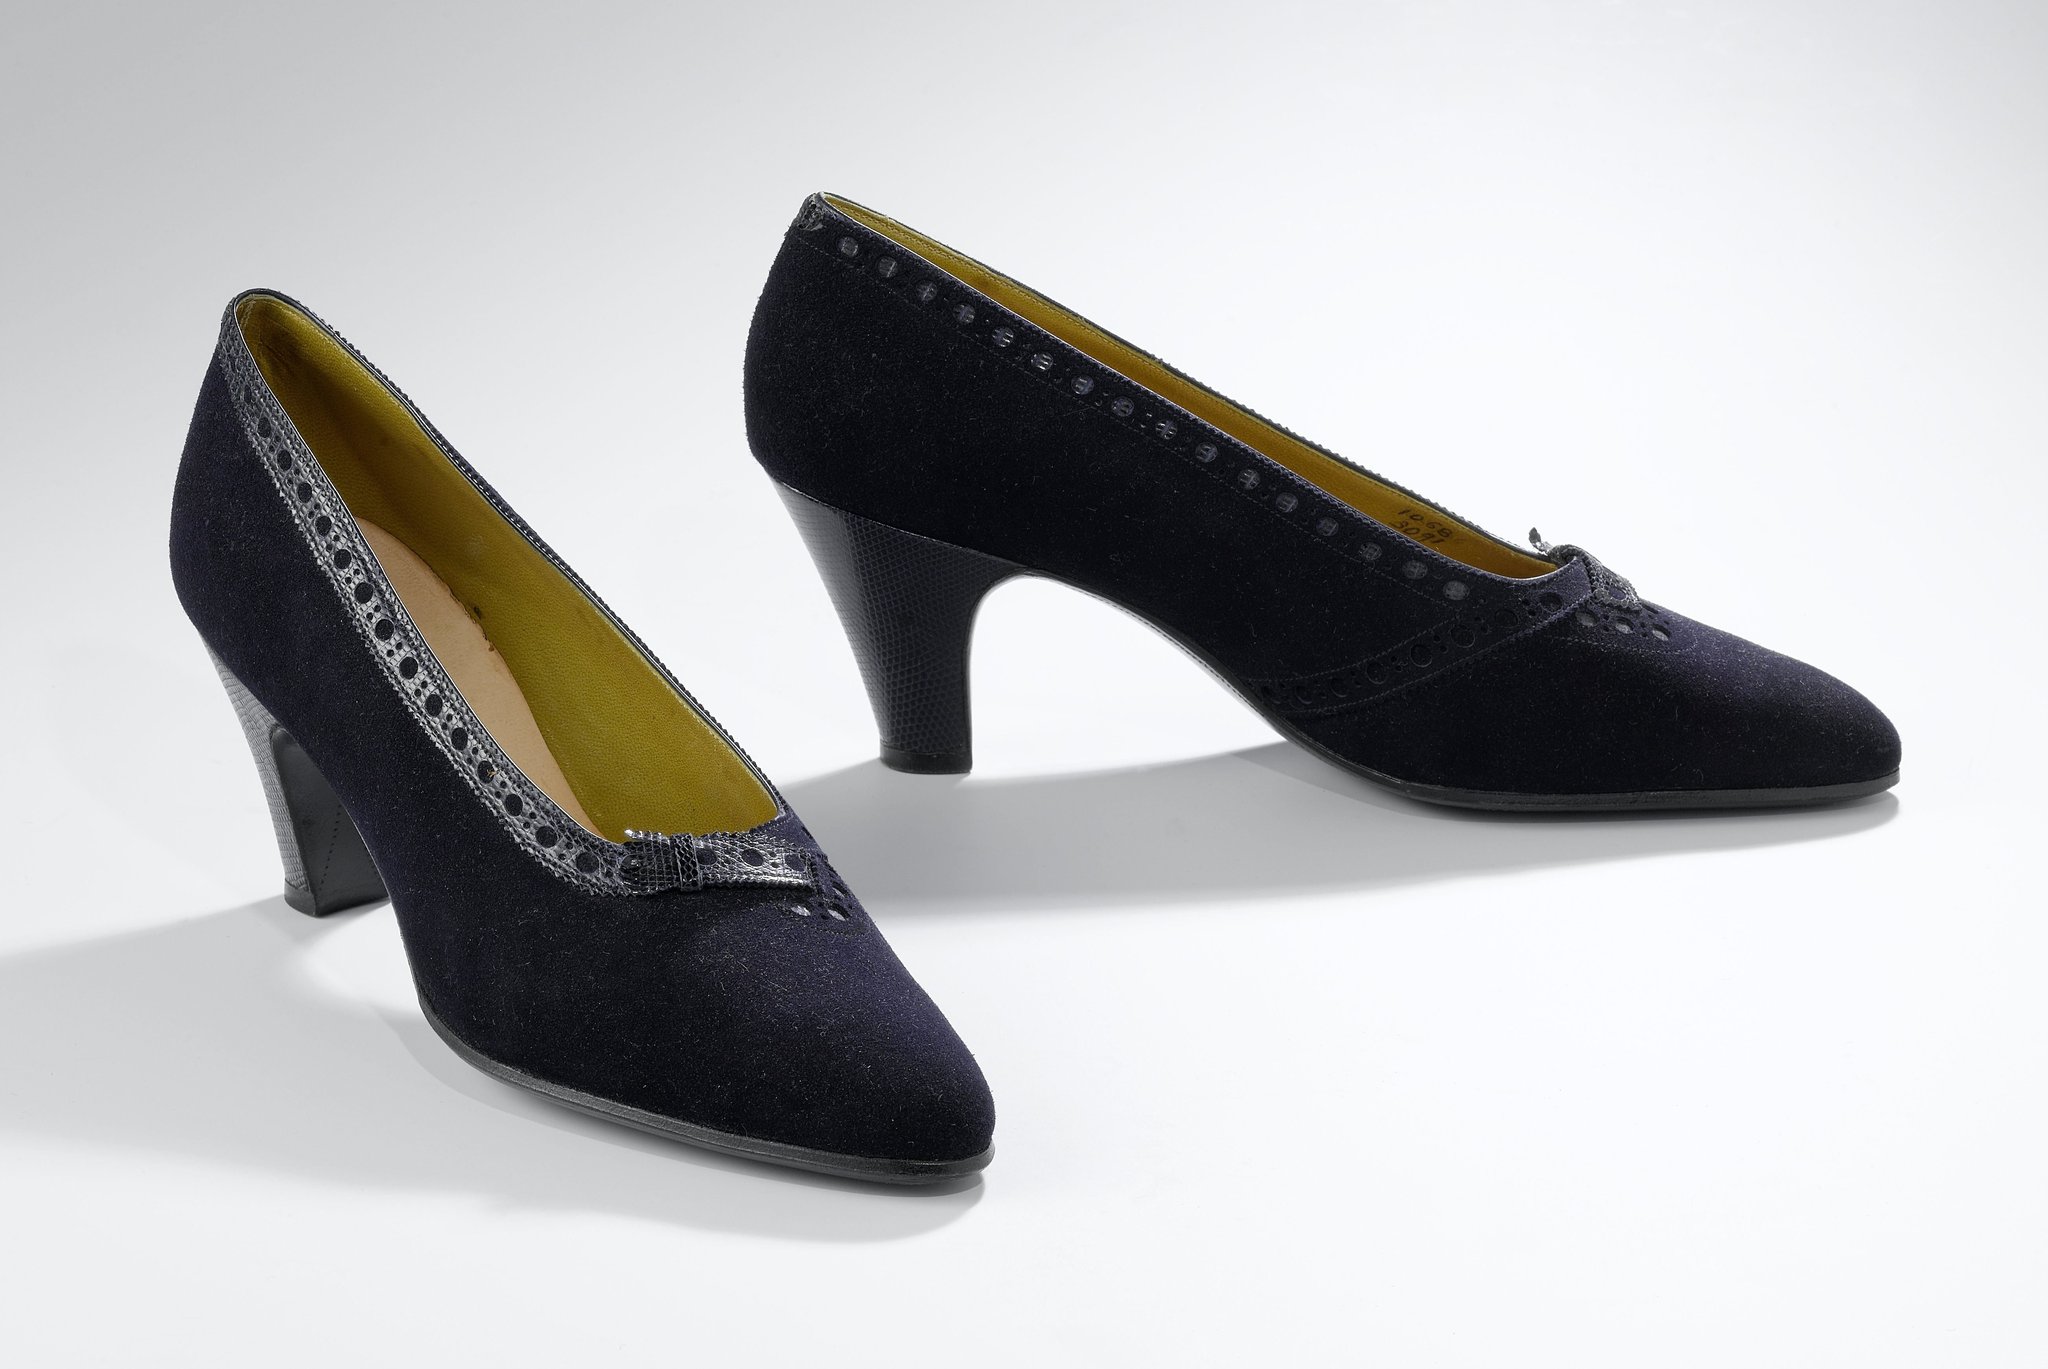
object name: pump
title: Pump van donkerblauwe suède versierd met donkerblauw slangenleer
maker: a. van goethem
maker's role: schoenmaker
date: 1937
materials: cotton, leather, skin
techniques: perforating, stitching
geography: brussels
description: Rechterpump van donkerblauwe suède versierd met donkerblauw slangenleer. Model: schoen is samengesteld uit twee panden die asymmetrisch en met de vleug in tegengestelde richting zijn verwerkt. Het pand aan de buitenkant van de voet loopt door tot over de neus. Het andere pand is hier halfrond overheen gewerkt. Hoge (7 cm) rechte hak. De voorvoet is gevoerd met naturelkleurige katoen; de zijkanten met okerkleurig leer. Naturel leren binnenzool met gouden opdruk. Versiering: rondom de instap een rand met perforaties. Aan de buitenkant van de voet is op het suède een gejartekde en geperforeerde band van blauw slangenleer aangebracht die vanaf de achternaad tot over het midden van de voorvoet loopt. Op de voorvoet is hij teruggeslagen en onder een riempje doorgehaald. Aan de binnenkant van de voet is onder het geperforeerde suède met sierstiksel, donkerblauw slangenleer aangebracht. Hak bekleed met donkerblauw slangenleer. Adres (op de binnenzool): A.VAN GOETHEM 15.RUE DE NAMUR/PRES LA PLACE ROYALE/BRUXELLES.